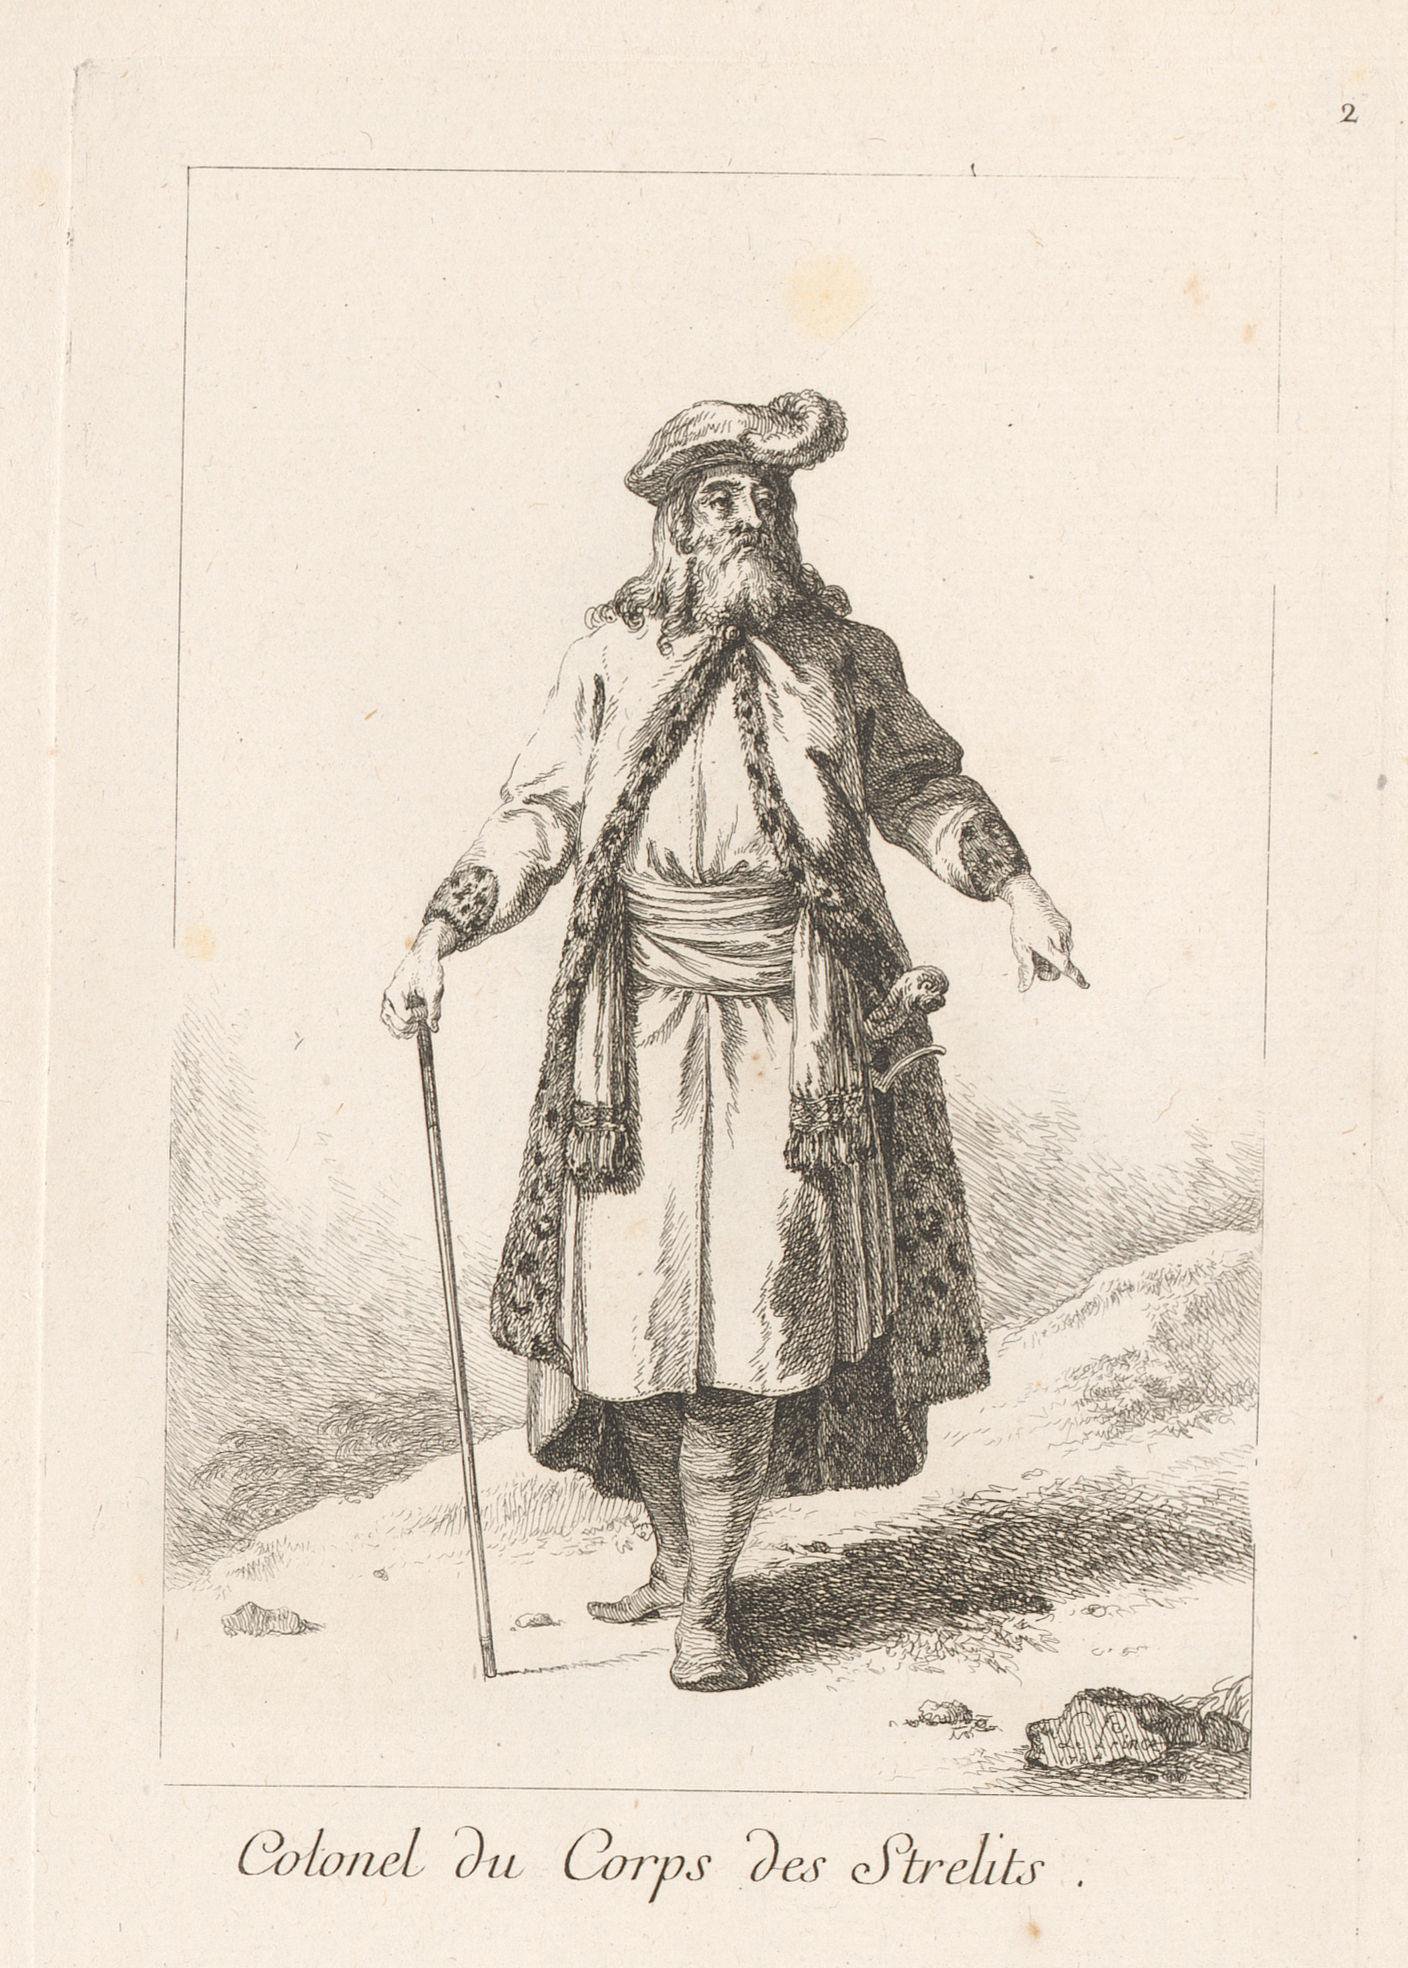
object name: print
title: Soldaten uit de eenheid Strelitsen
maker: jean baptist leprince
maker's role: draughtsman, print maker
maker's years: 1734-1781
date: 1764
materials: paper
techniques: etching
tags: ranks in the army, land forces, firearms